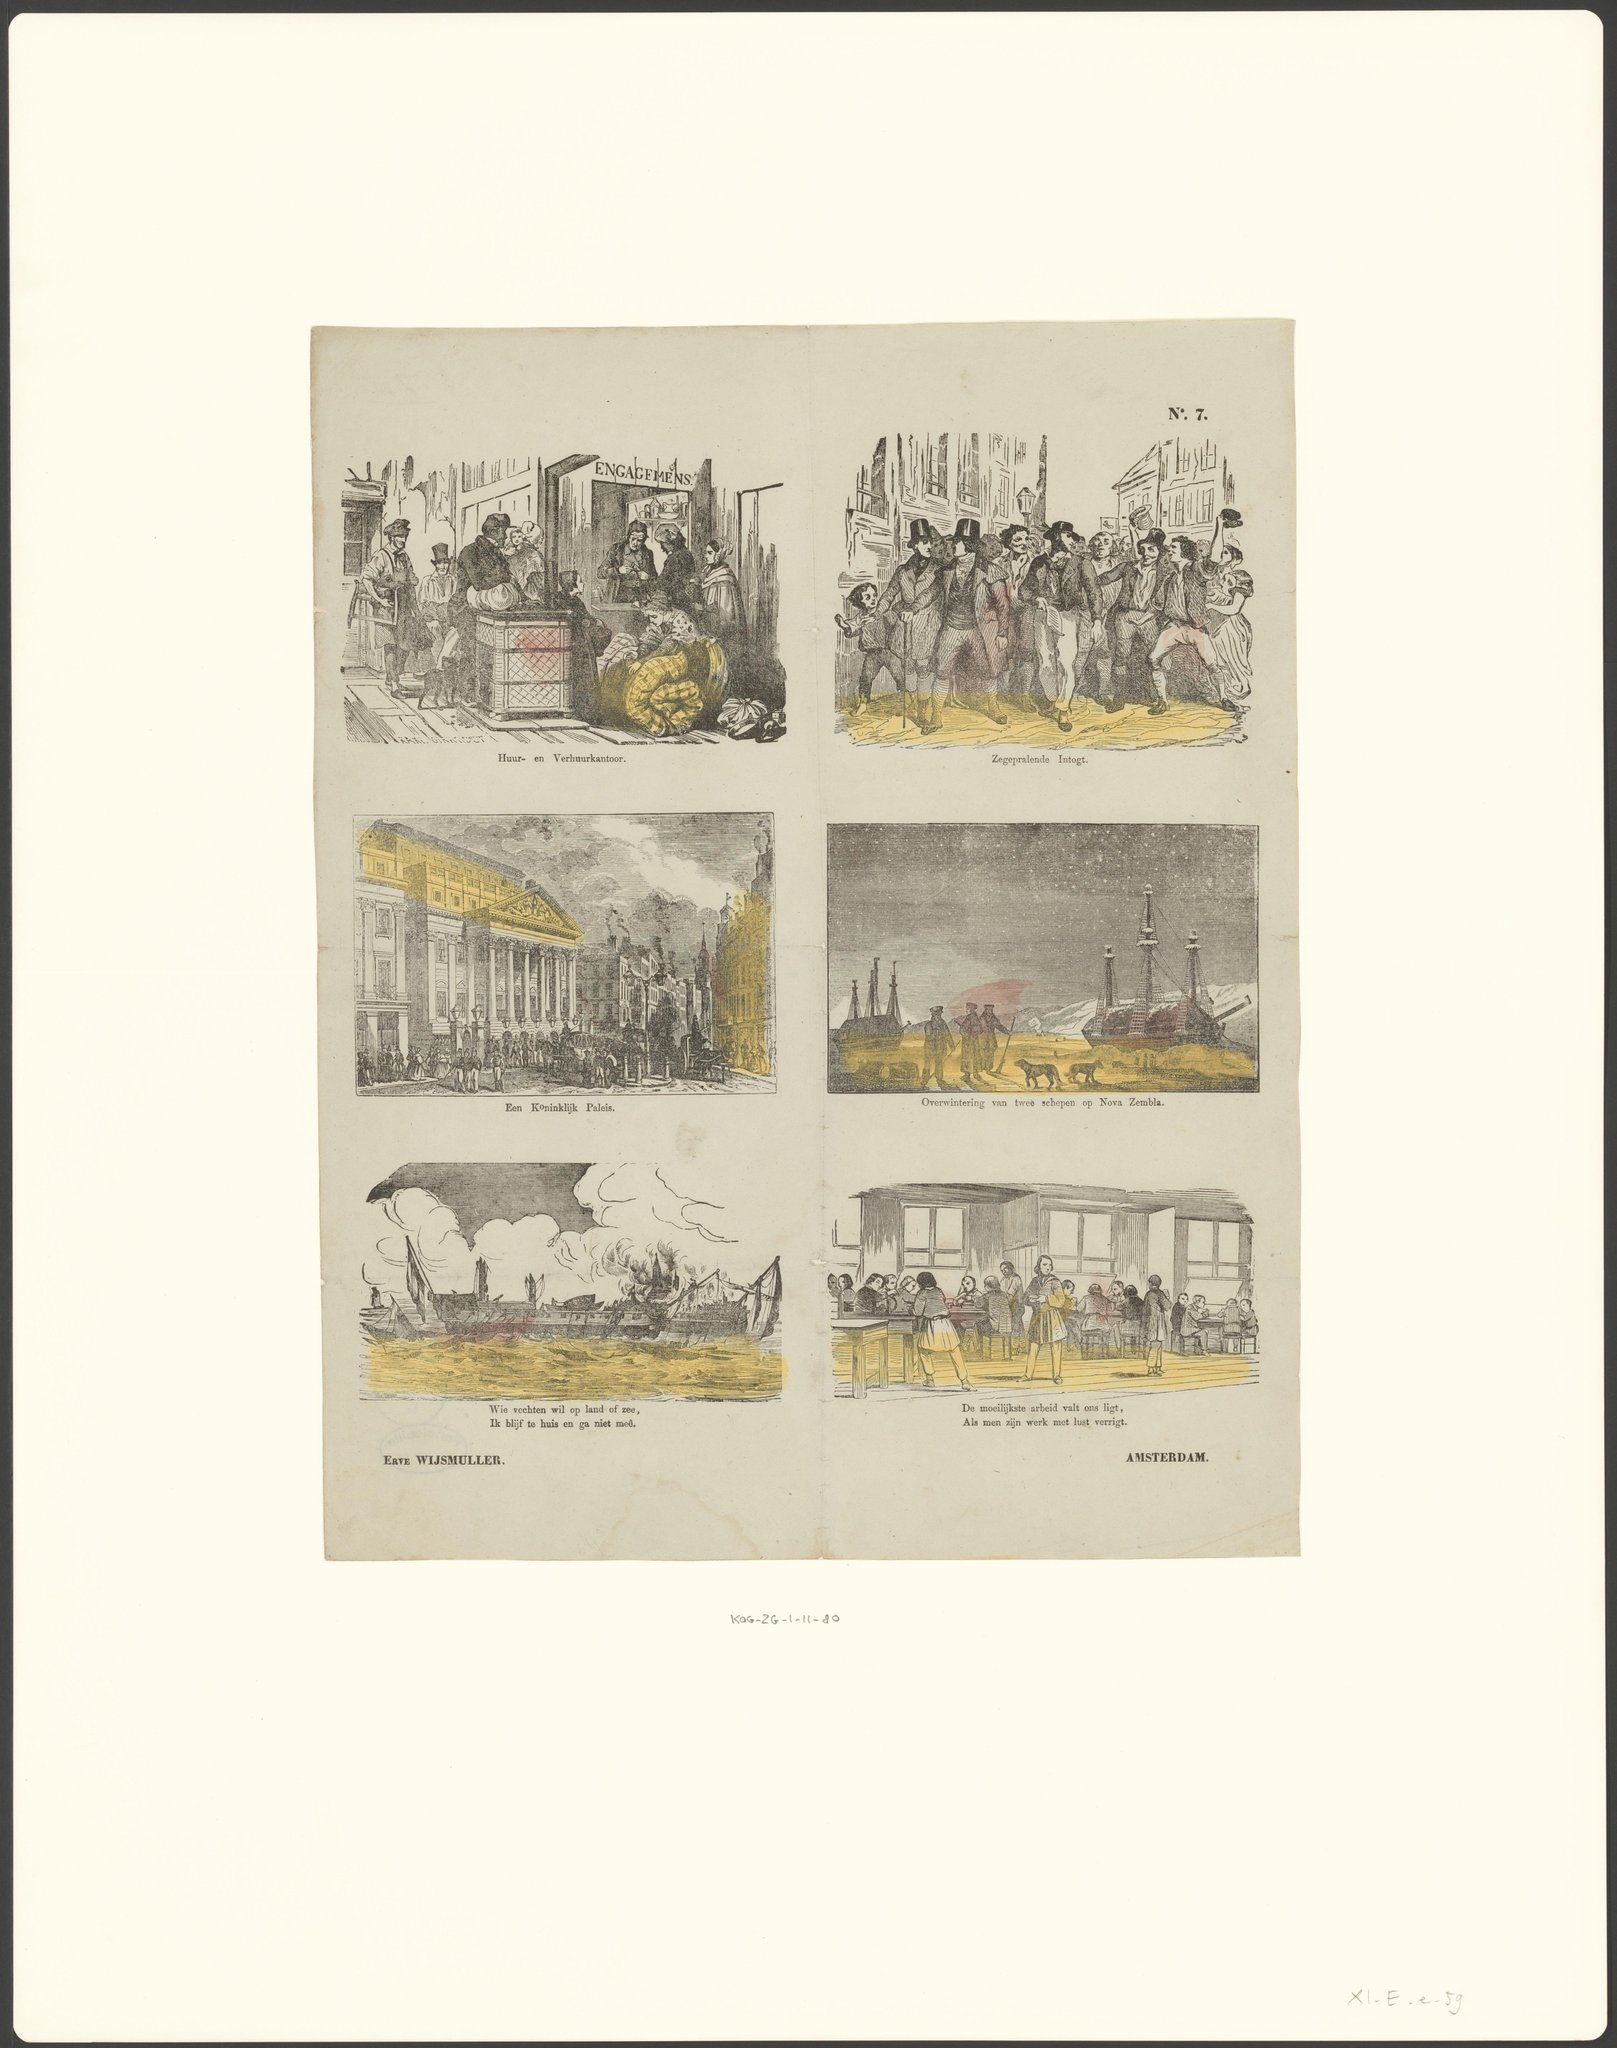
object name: print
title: Verschillende voorstellingen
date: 1828-1913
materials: paper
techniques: hand coloring, letterpress printing, line block, engraving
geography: amsterdam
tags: ships (in general), office (~ administration), royal palace of amsterdam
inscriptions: collector's mark: Lugt 1641, stamp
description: Blad met zes voorstellingen van verschillende aard, waaronder een intocht, het Paleis op de Dam, de overwintering op Nova Zembla en een gehavend schip. Onder elke afbeelding een onderschrift. Onder de eerste afbeelding het onderschrift: Huur- en verhuurkantoor. Genummerd rechtsboven: No. 7. Onderwerpsrubrieken binnen de Atlas Zeden en Gewoonten: Handel, nijverheid en verkeer, Koophandel, Veilingen, Makelaardij en Verzekeringswezen. Kamers te huur.